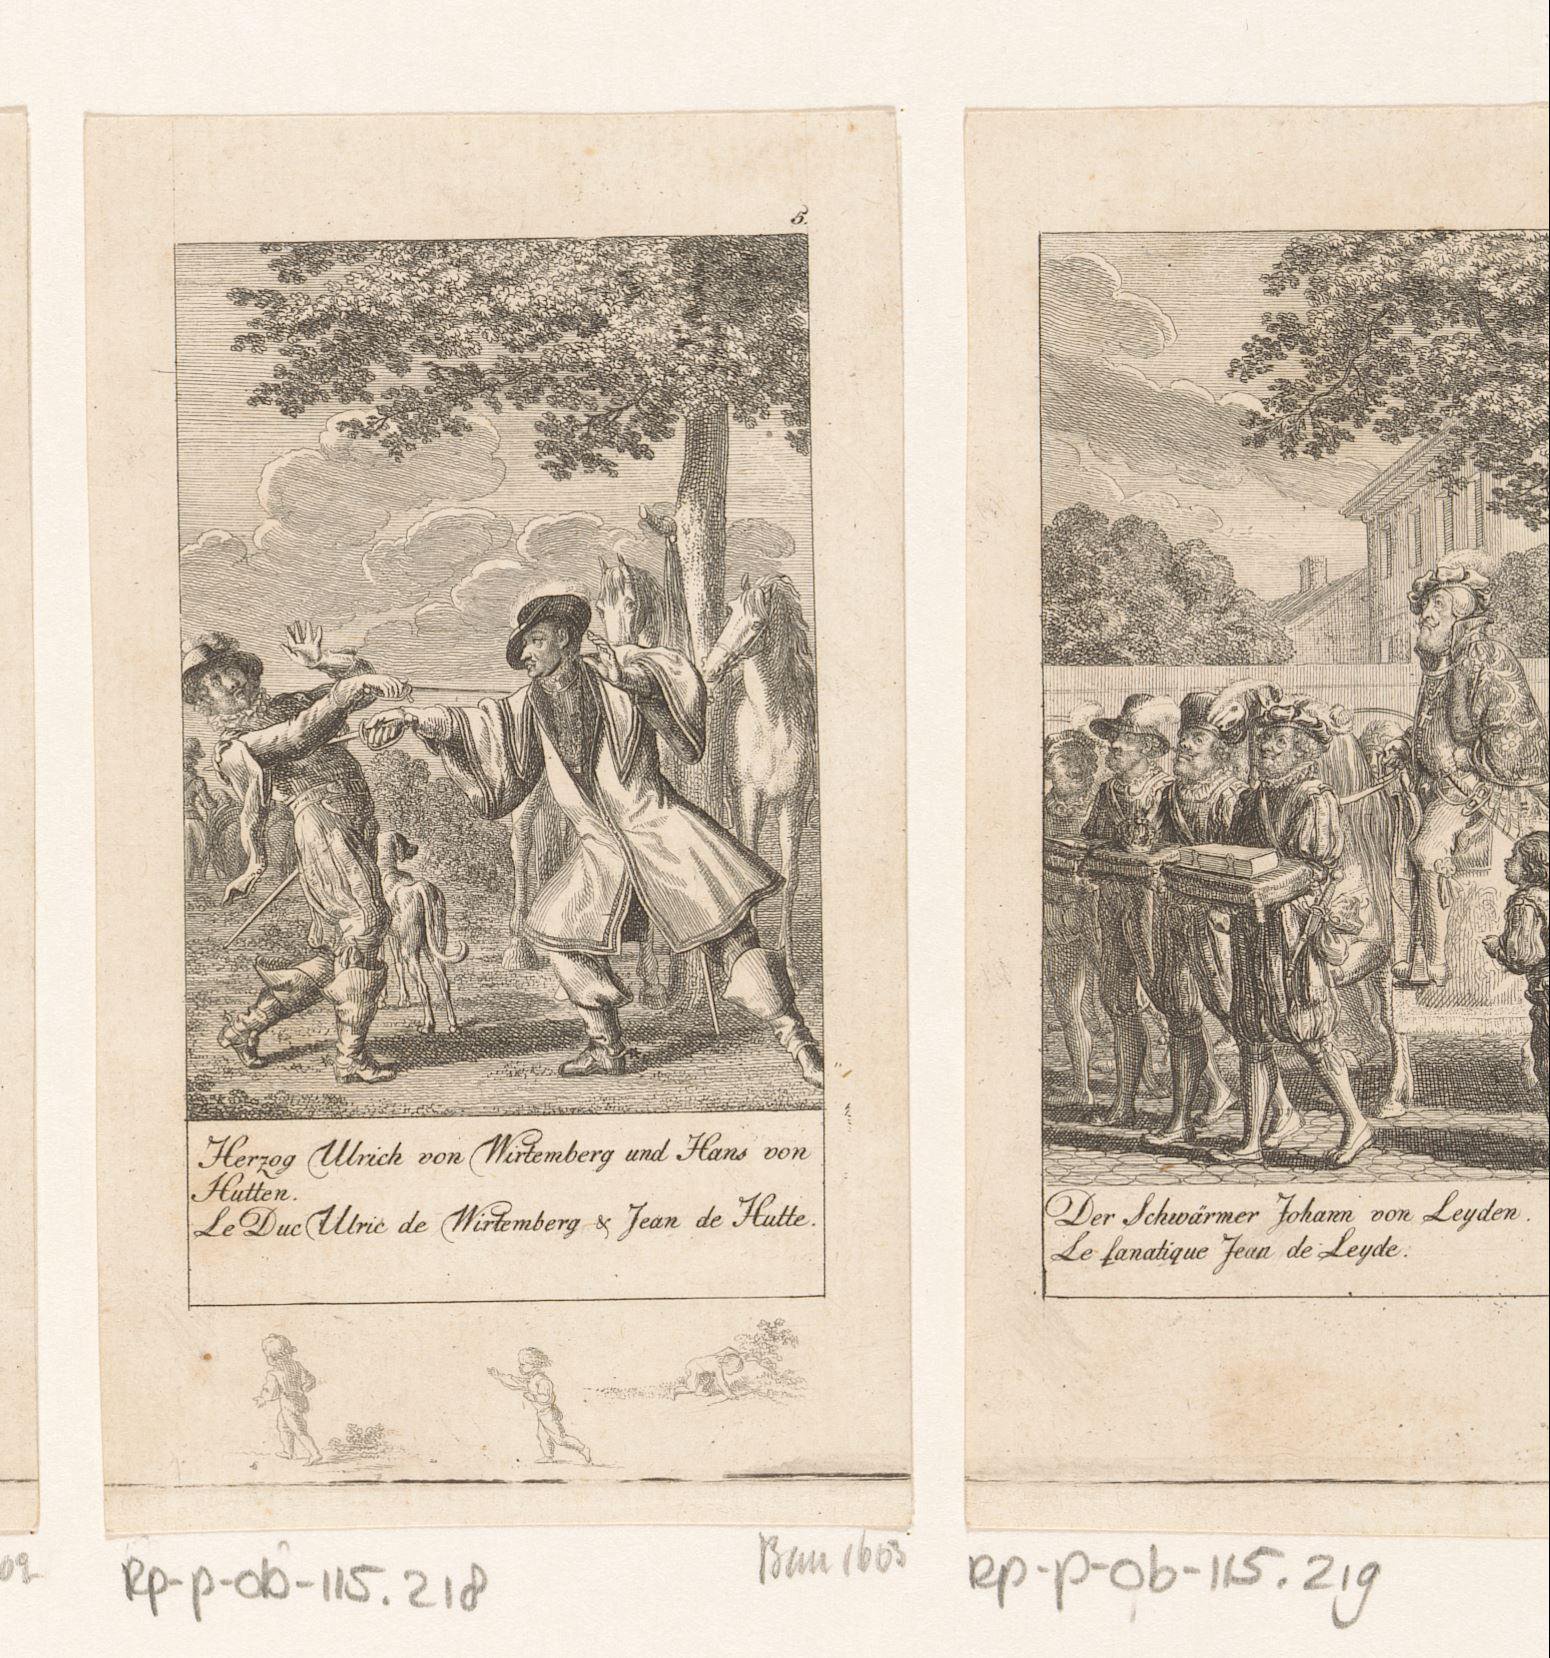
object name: print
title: Duel tussen Ulrich van Württemberg en Hans van Hutten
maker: daniel nikolaus chodowiecki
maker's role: draughtsman, print maker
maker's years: 1726-1801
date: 1792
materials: paper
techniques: etching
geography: berlin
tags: history, duelling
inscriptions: collector's mark: Lugt 2228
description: Rechtsboven genummerd: 5. Met onderschrift in het Duits en Frans. In de ondermarge zijn drie kinderen op schetsmatige wijze geëtst.